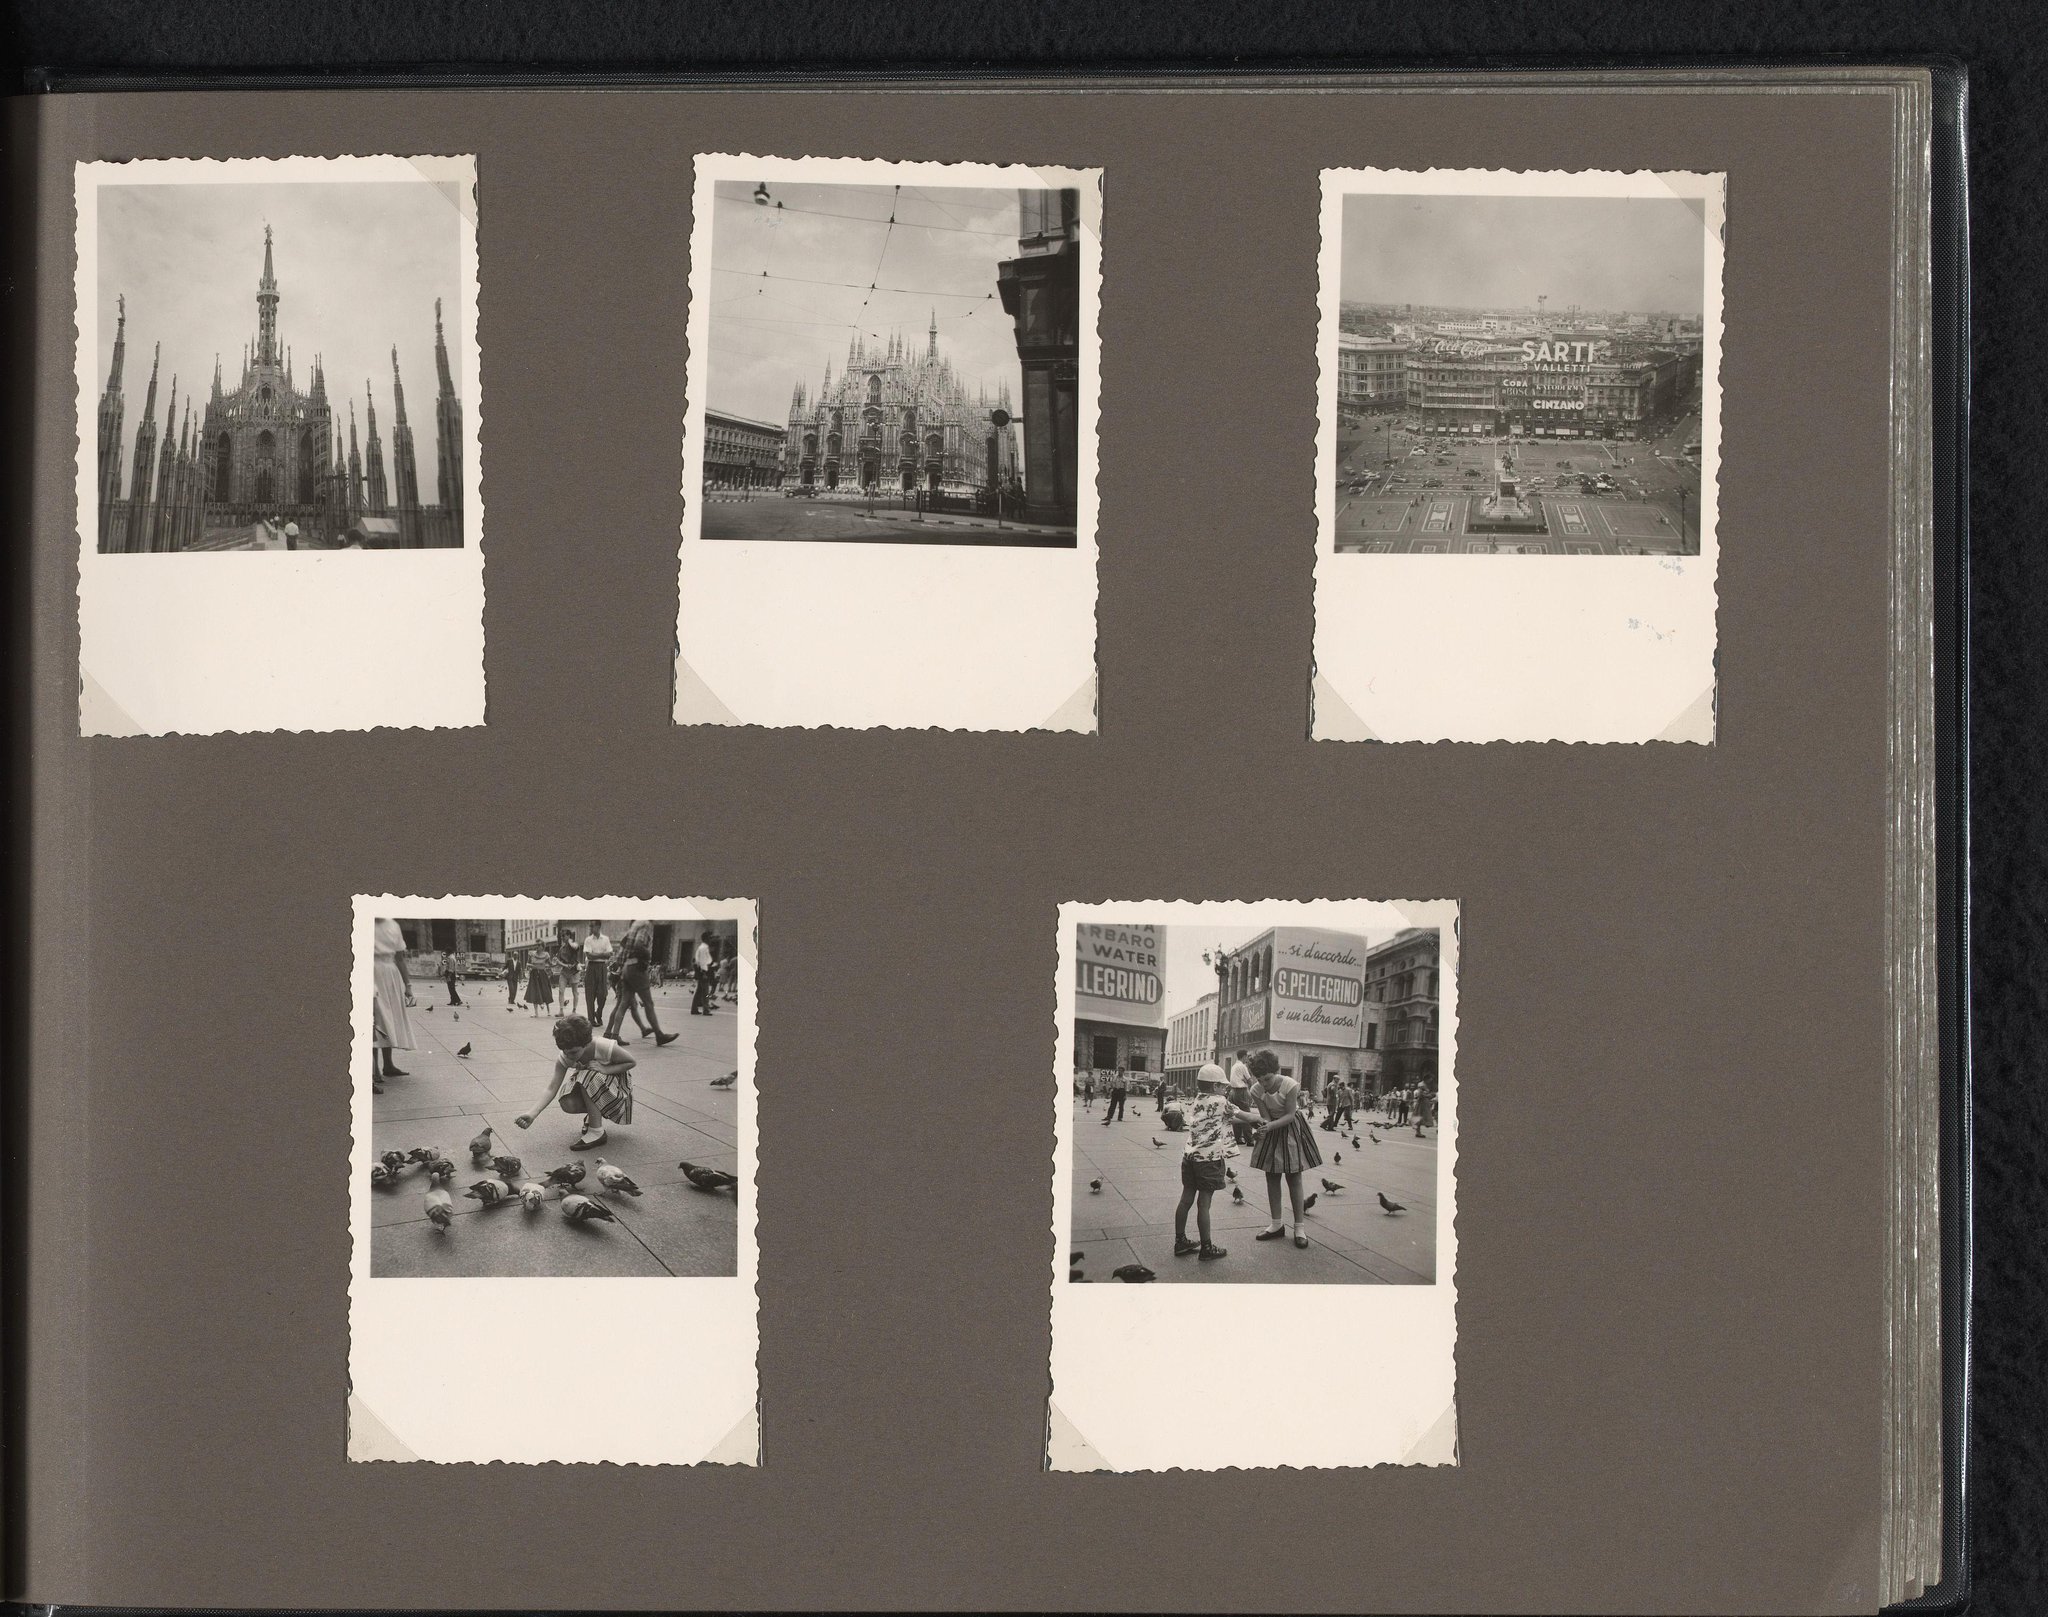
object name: photograph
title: Straatgezichten in Milaan, met de Kathedraal van Milaan en kinderen die duiven voeren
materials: paper, cardboard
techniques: gelatin silver print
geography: milan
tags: city-view in general; 'veduta', roman catholic church, doves, pigeons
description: Blad bevat vijf foto's, zonder personen gerelateerd aan de familie Wachenheimer. Deze foto's maken deel uit van een album.